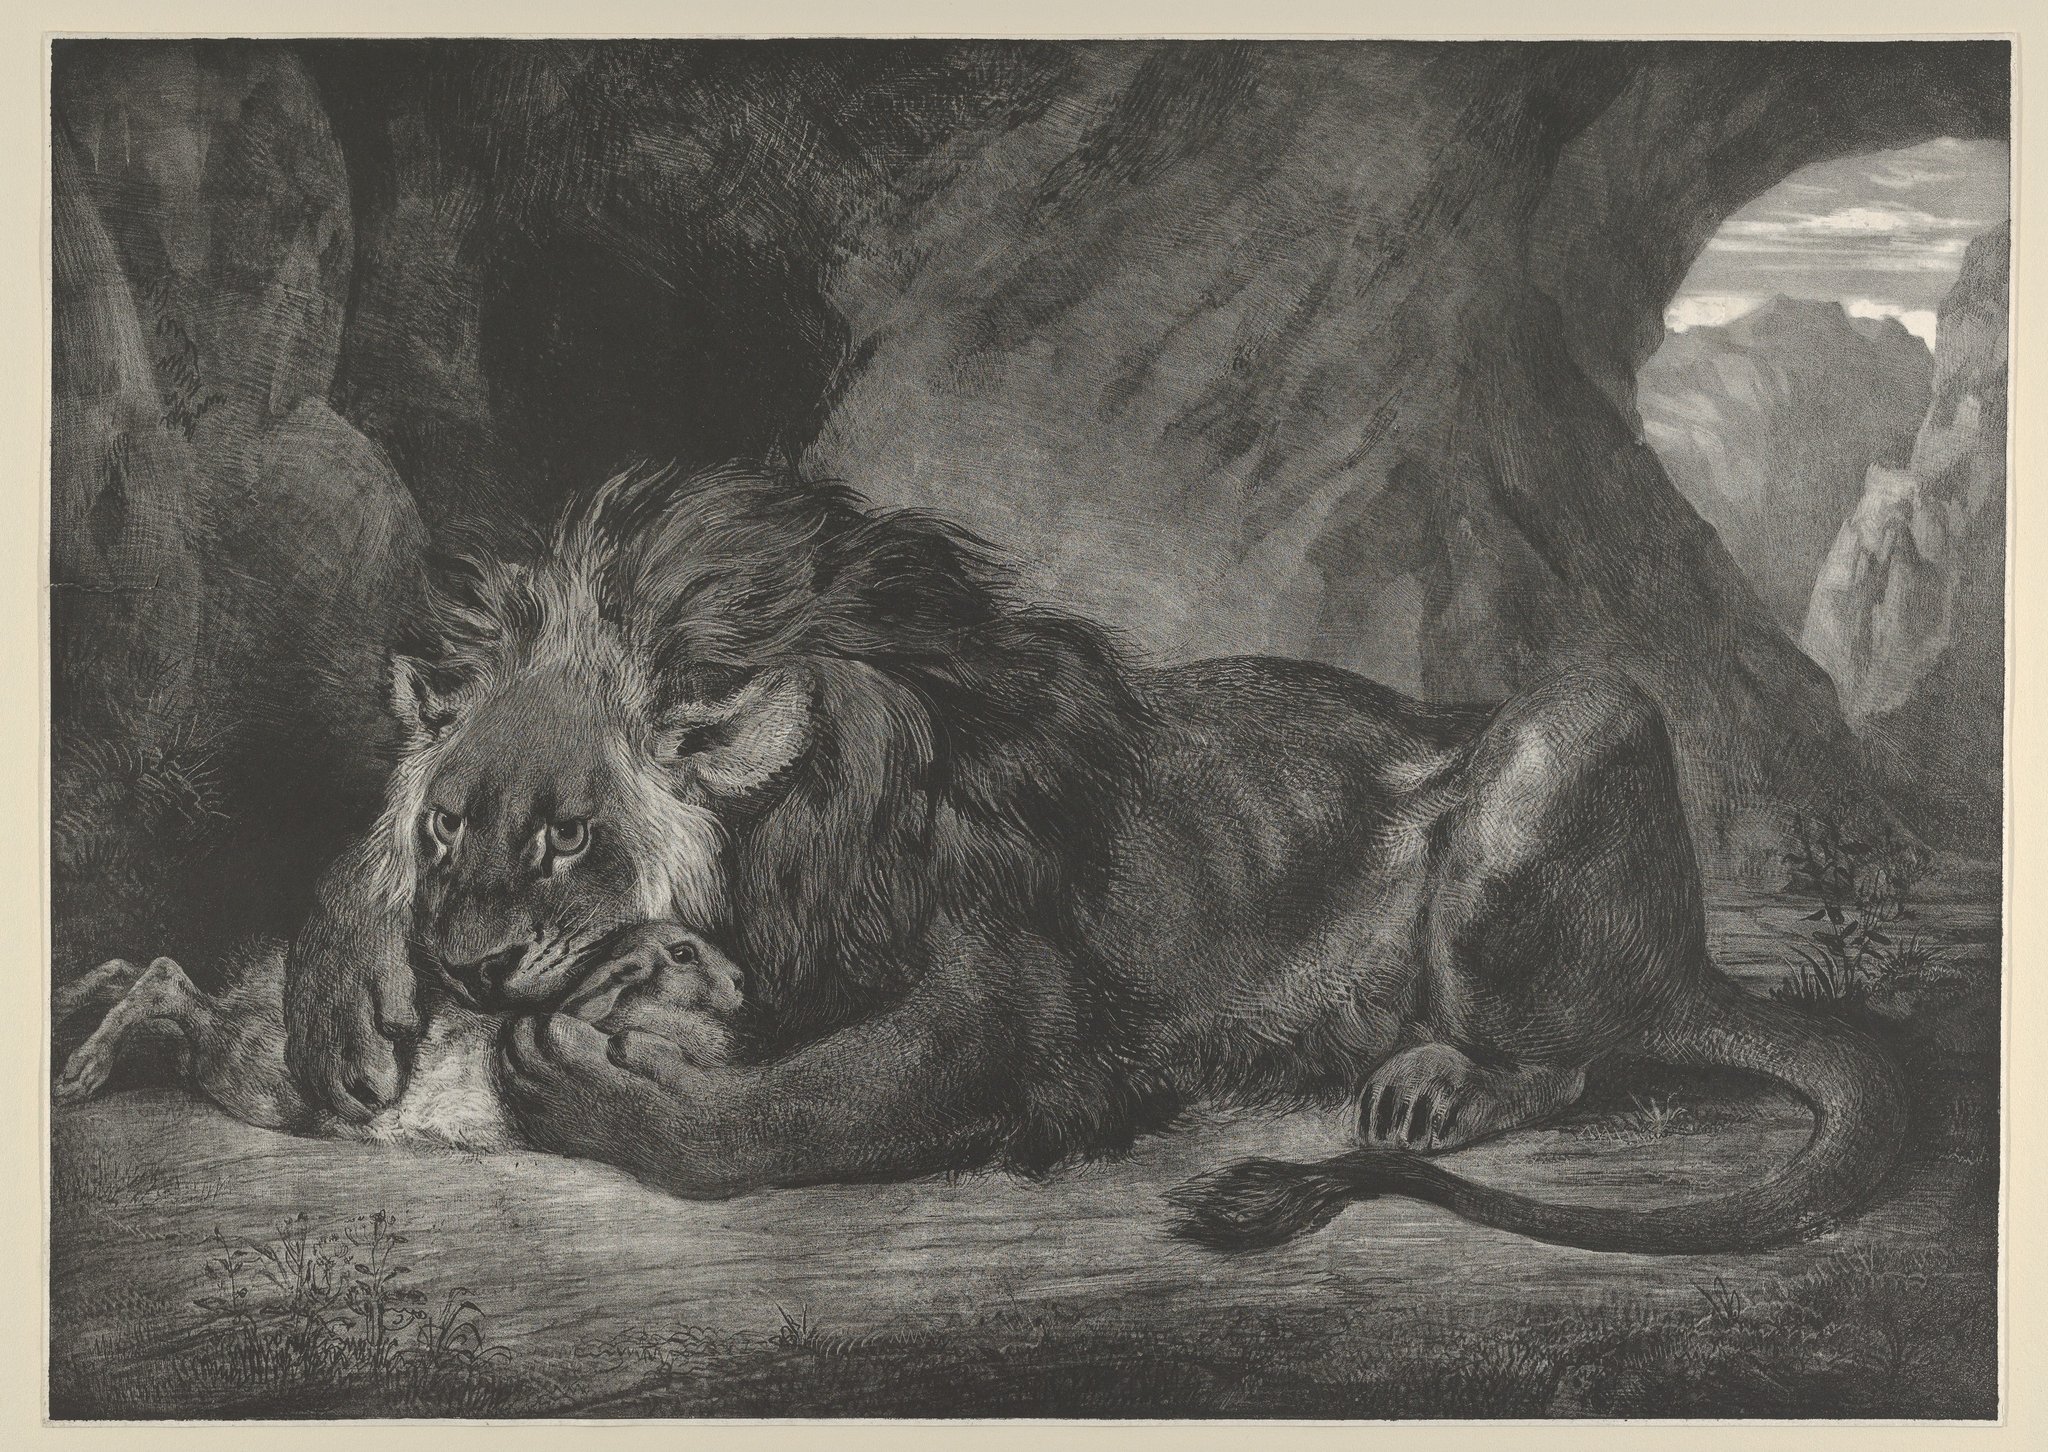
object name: print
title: Lion of the Atlas Mountains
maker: eugène delacroix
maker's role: artist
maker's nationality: french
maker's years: 1798-1863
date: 1829-1830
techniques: lithograph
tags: lions,rabbits,caves,mountains